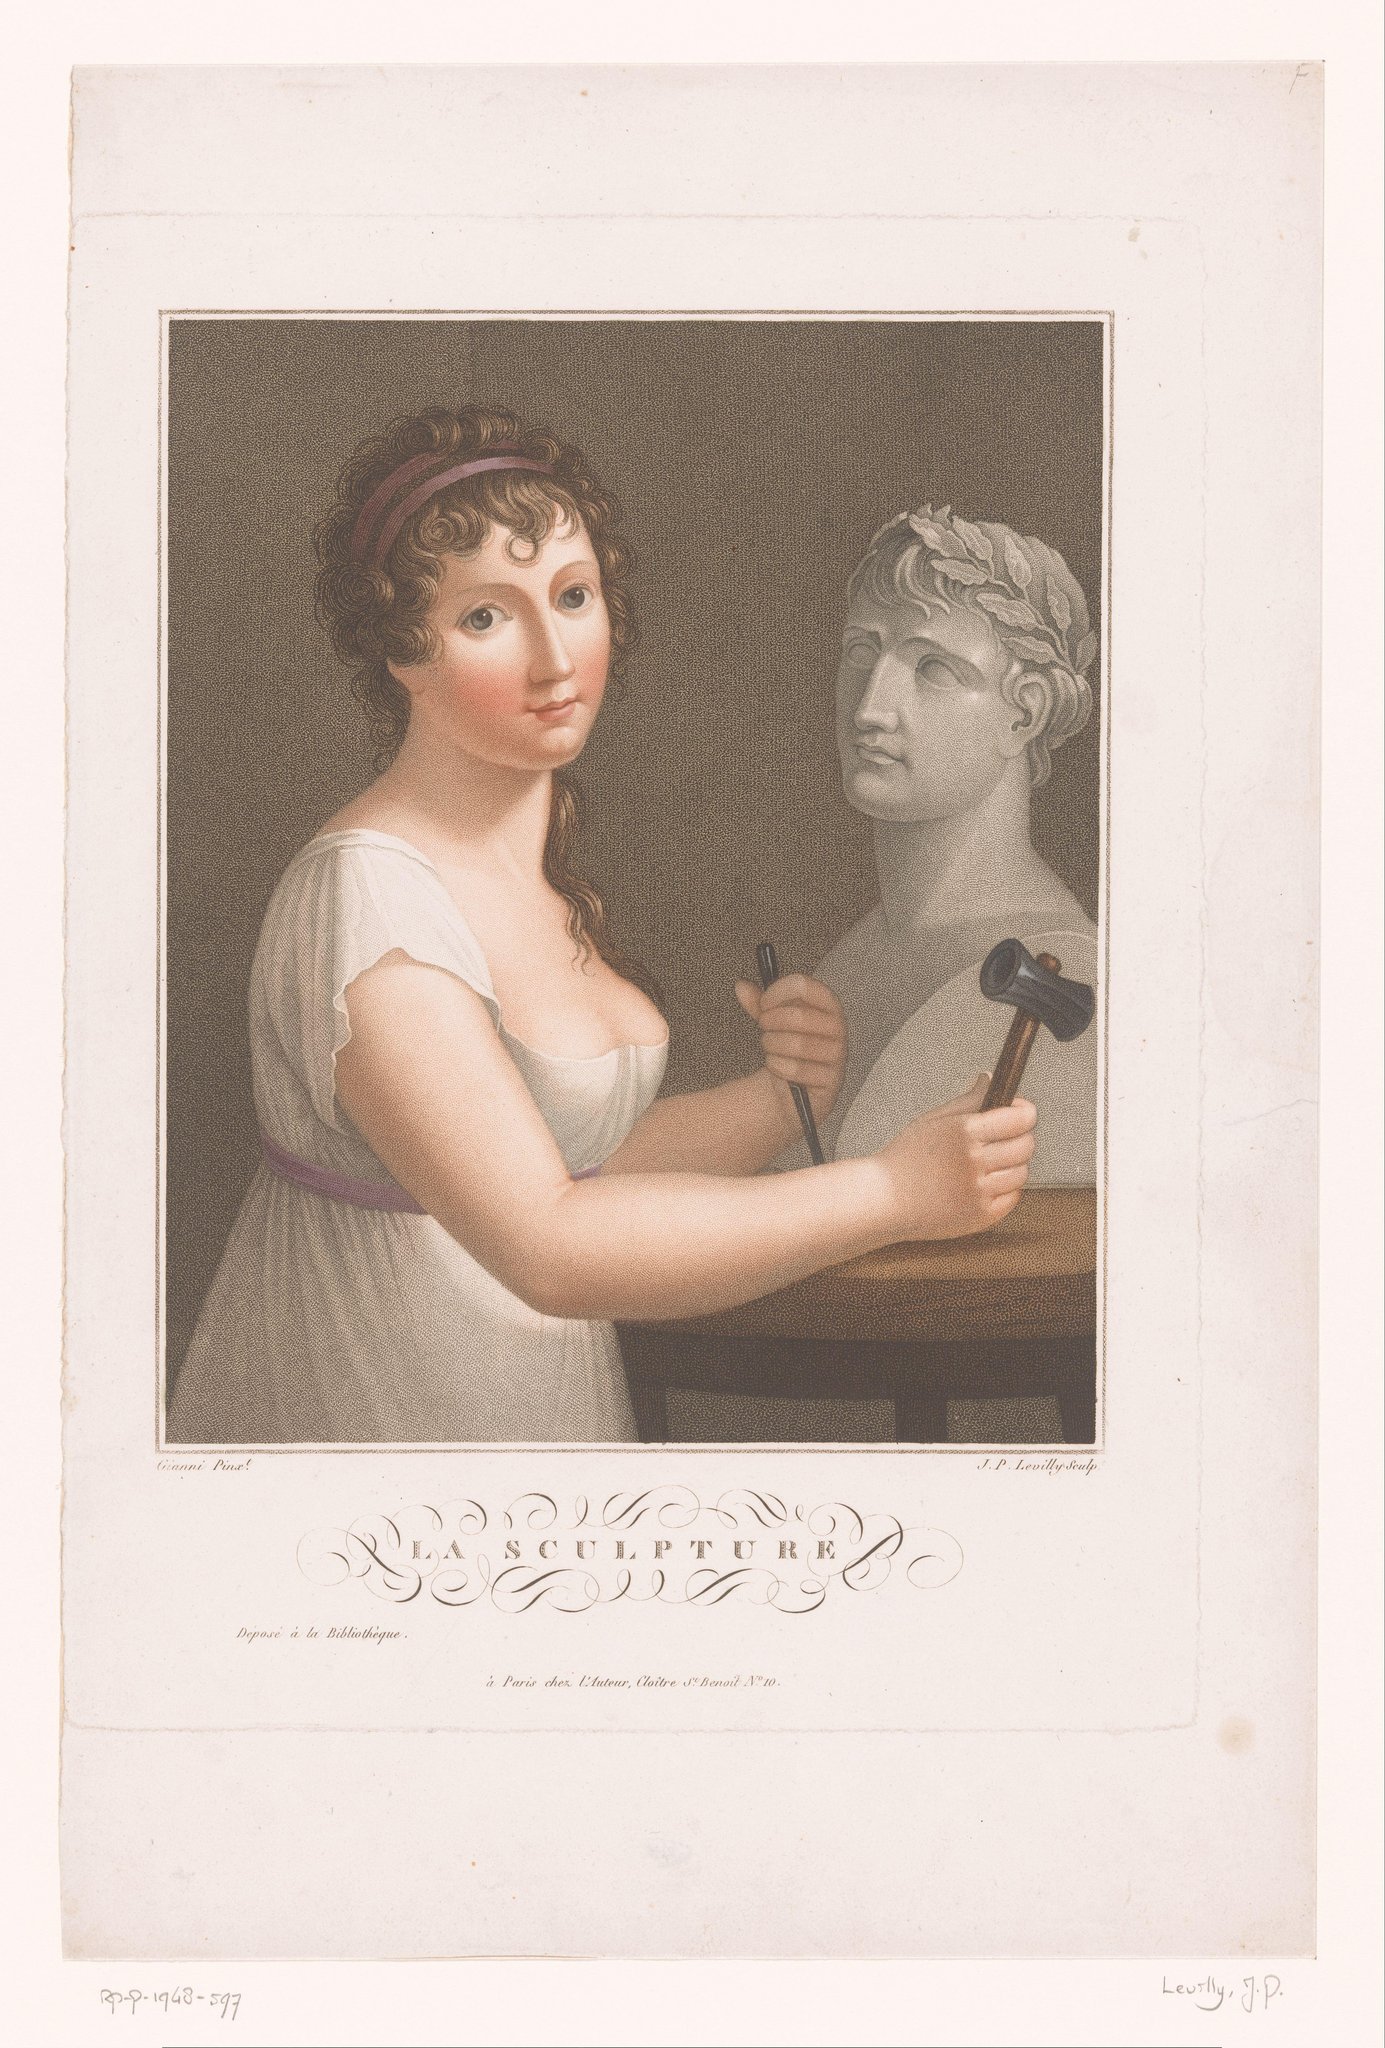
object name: print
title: Personificaties van de Kunsten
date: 1780-1800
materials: paper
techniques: engraving, lithography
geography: paris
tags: sculptor at work, 'sculptura', symbolic representations, allegories and emblems ~ sculpture; 'scoltura' (ripa), tools, implements of sculptor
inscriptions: collector's mark: Lugt 2228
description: Maakt deel uit van een vierdelige serie met personificaties van de Kunsten.